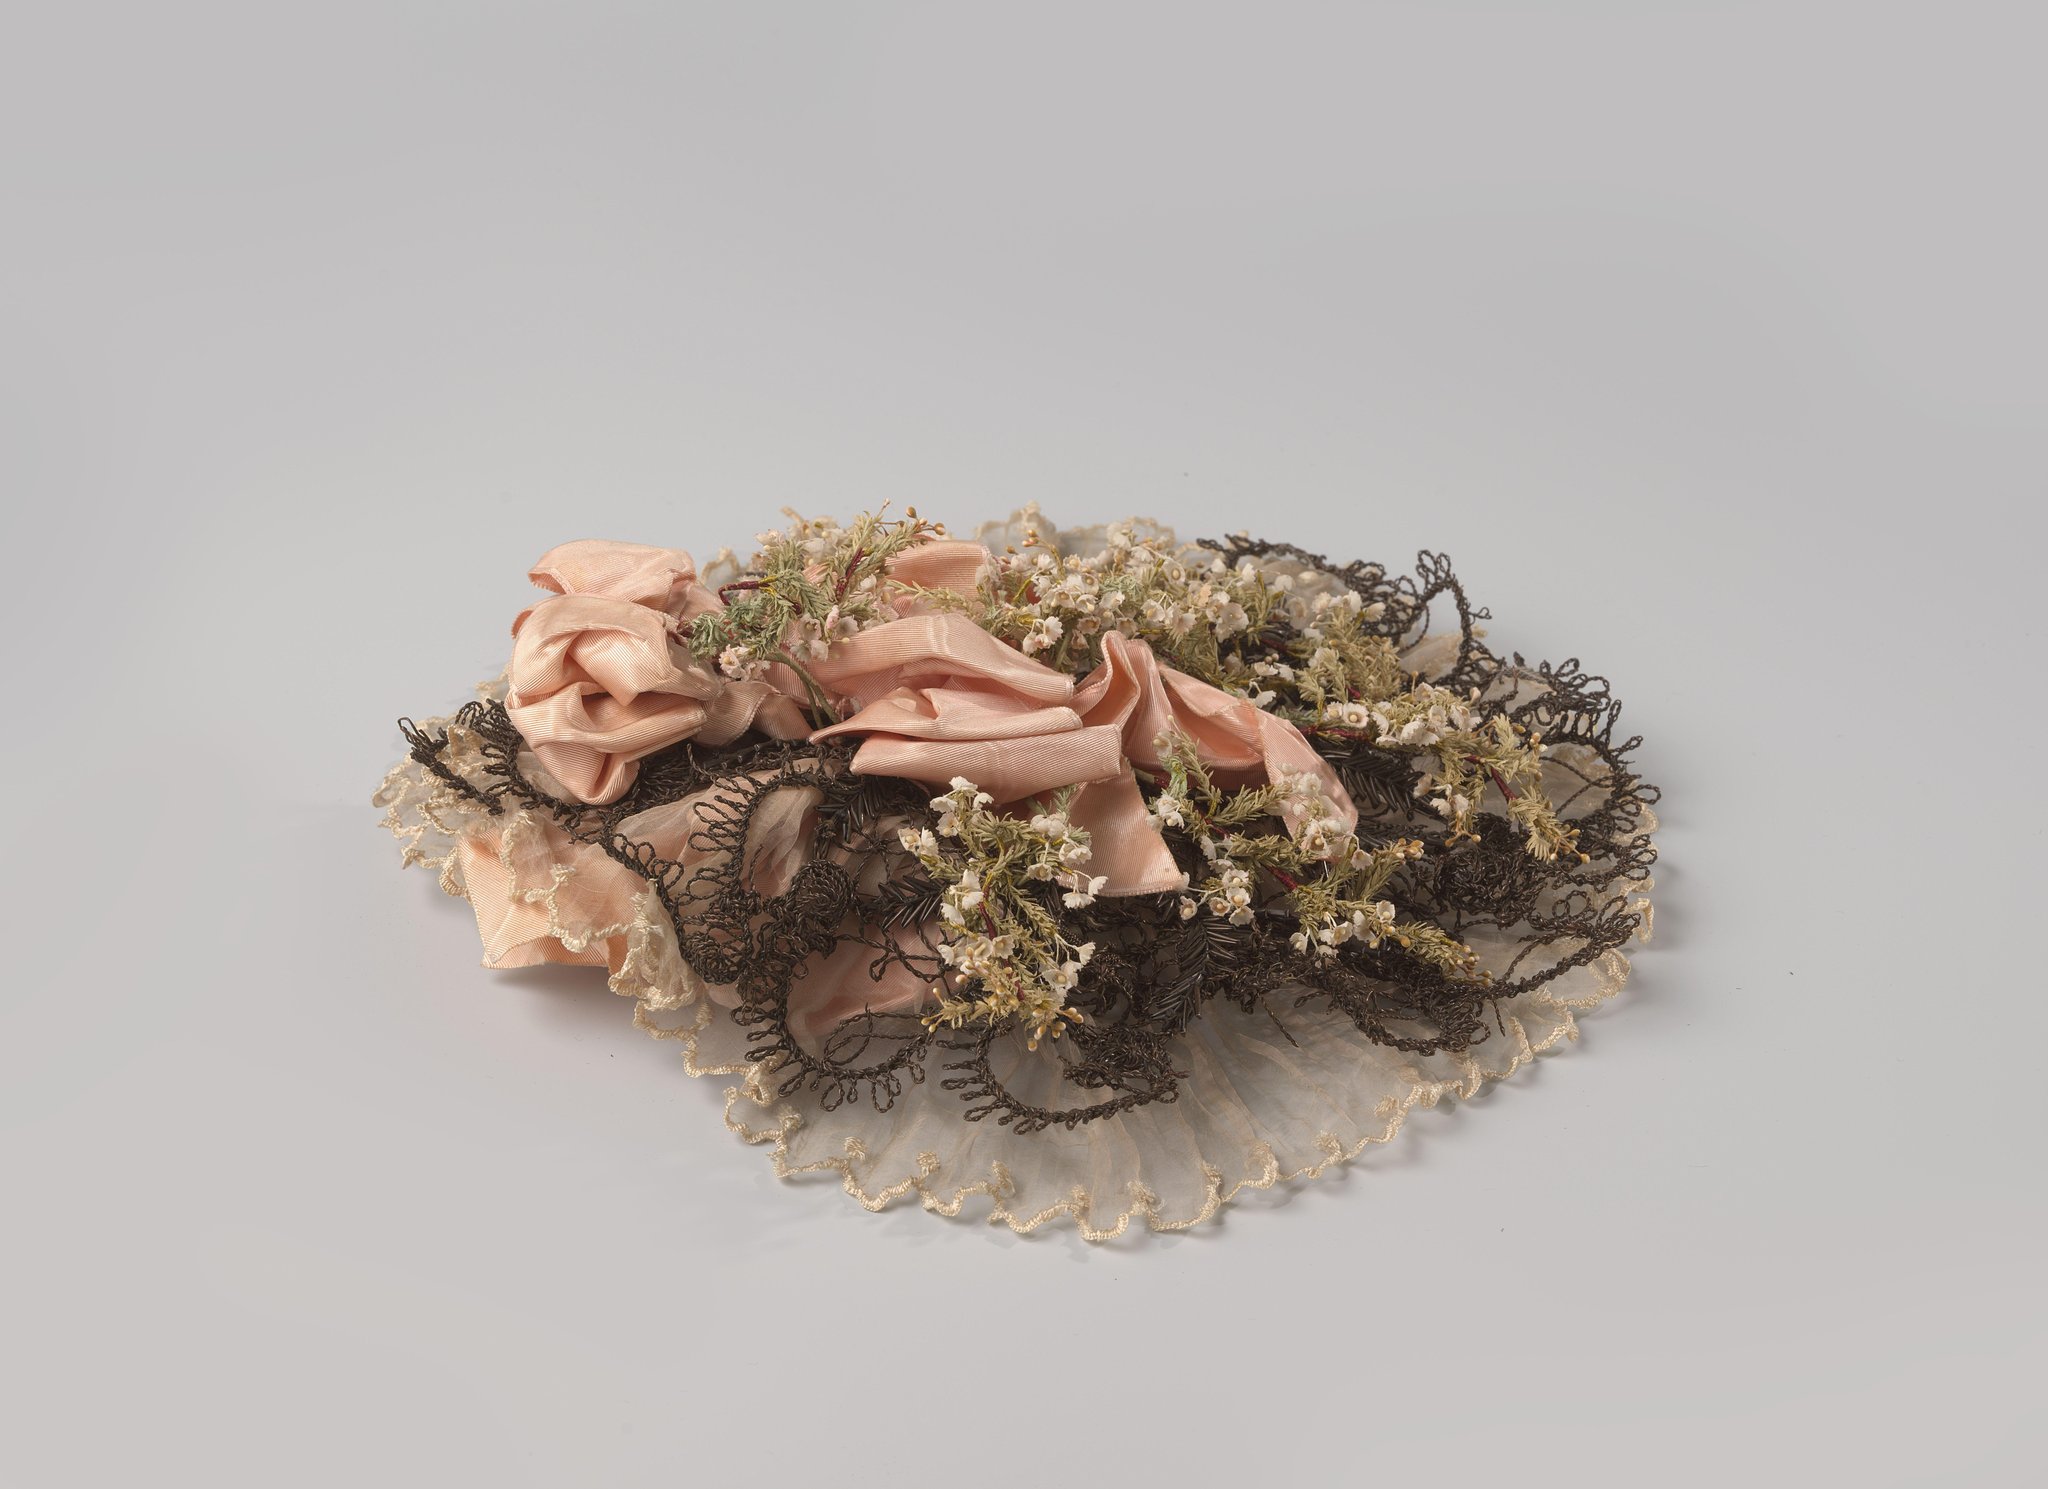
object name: hat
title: Hoed van zwart laiton, rose zijden gaas, rose moiré strikken en kunstbloemen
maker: Anonymous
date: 1860-1875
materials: cotton, metal, silk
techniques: moire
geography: netherlands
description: Hoed van zwart laiton, rose zijden gaas, rose moiré strikken en kunstbloemen. Het model bestaat uit een vlakke bol van open slingers laiton met schulprand met tegengezette geplisseerde geschulpte en met festonsteken afgezette rand van zijden gaas, van voren hoog opgewerkt. Bovenop zijn uitstralende takjes gestoken met fijn groen en trosjes wit/rose bloempjes en knopjes. Aan de voorkant opgewerkt met twee strikken van zacht rose moirézijde, in een zestal lussen, nog een dergelijke strik binnen tegen de rand.